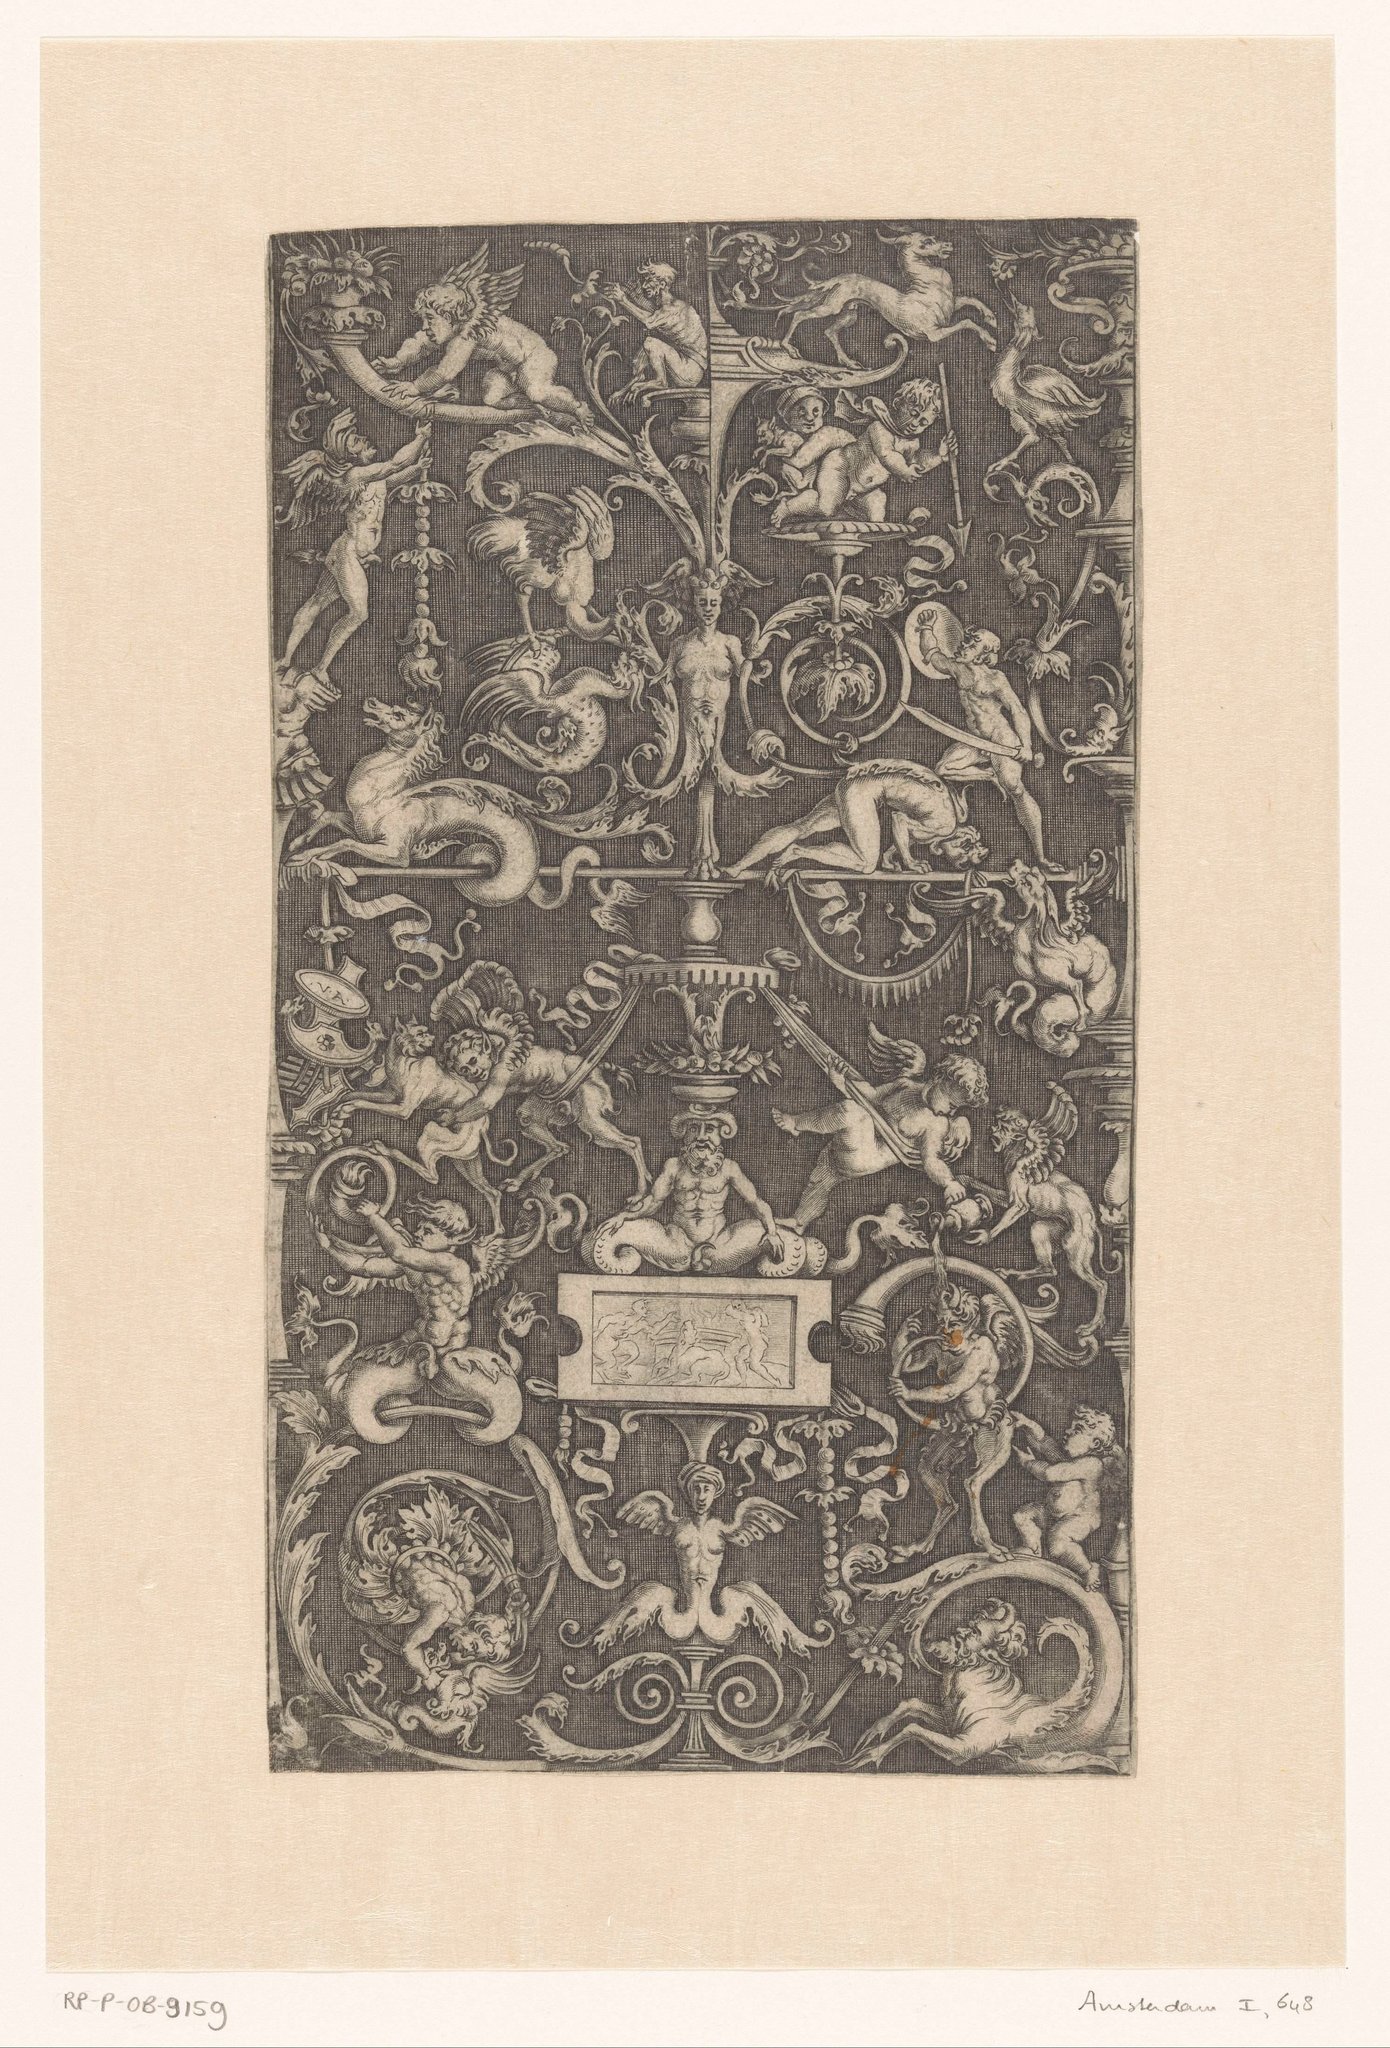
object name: print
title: Ornamenteel paneel met grotesken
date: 1500-1536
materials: paper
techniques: engraving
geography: italy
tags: ornament ~ grotesque, sea-horse, hippocamp, 'hippocampus', (horse/fish) (mythological hybrid monster), satyr(s) (in general), cupids: 'amores', 'amoretti', 'putti'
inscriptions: collector's mark: Lugt 12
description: Ornamenteel paneel met groteske motieven, bestaande uit onder andere putti, saters, een hippocampus en duivelse wezens.